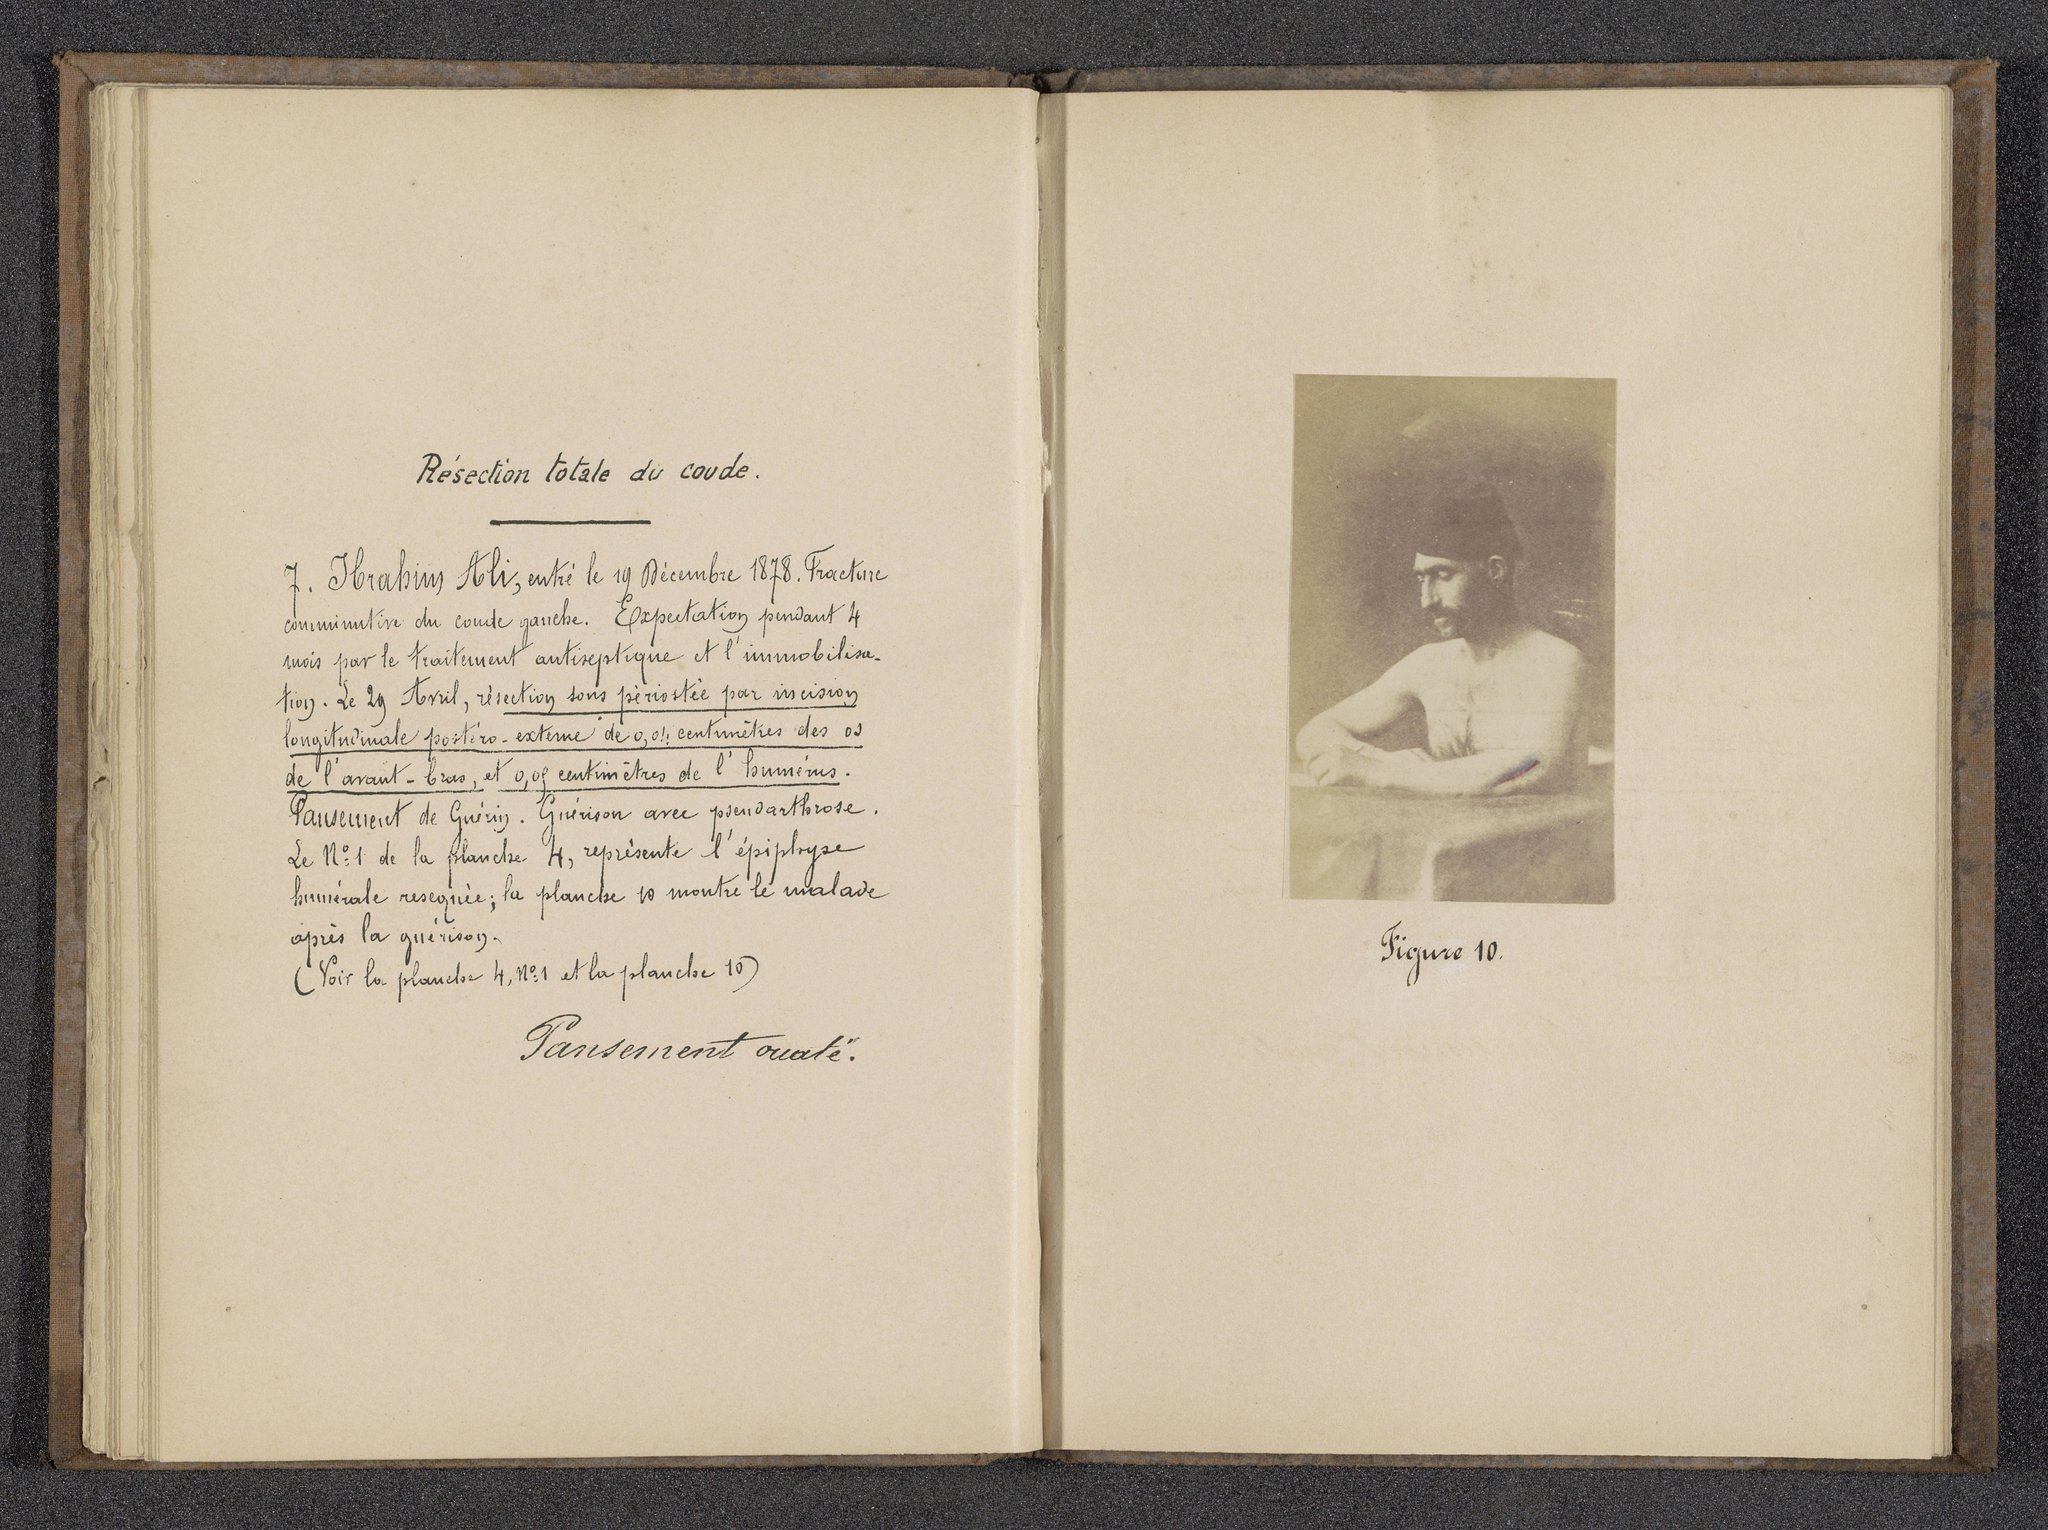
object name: photograph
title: Portret van Ibrahim Ali na een operatie aan zijn onderarm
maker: Anonymous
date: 1878-1880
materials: photographic support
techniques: albumen print, hand coloring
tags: patient, sick person, bones of the arms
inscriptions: number: ‘Figure 10.’